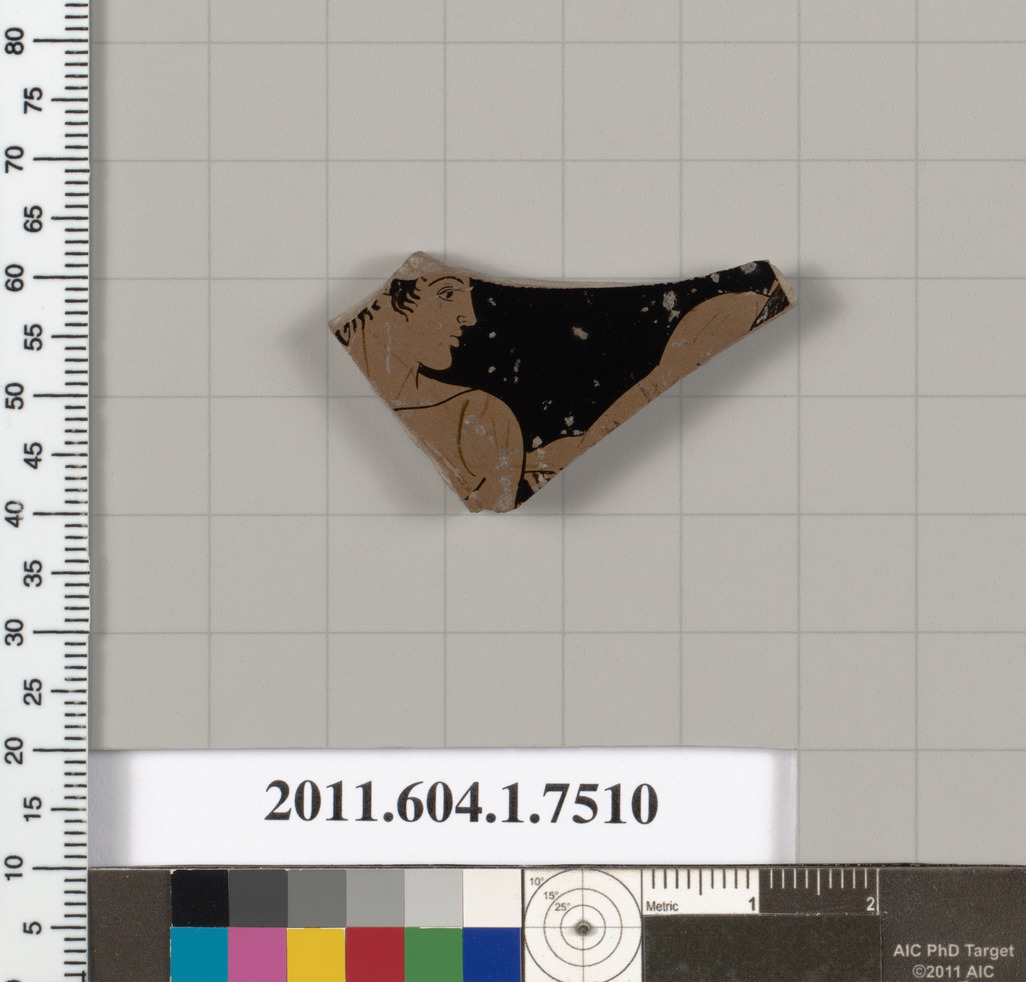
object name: kylix fragment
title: Terracotta fragment of a kylix (drinking cup)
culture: greek, attic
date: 460-450 BCE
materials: terracotta